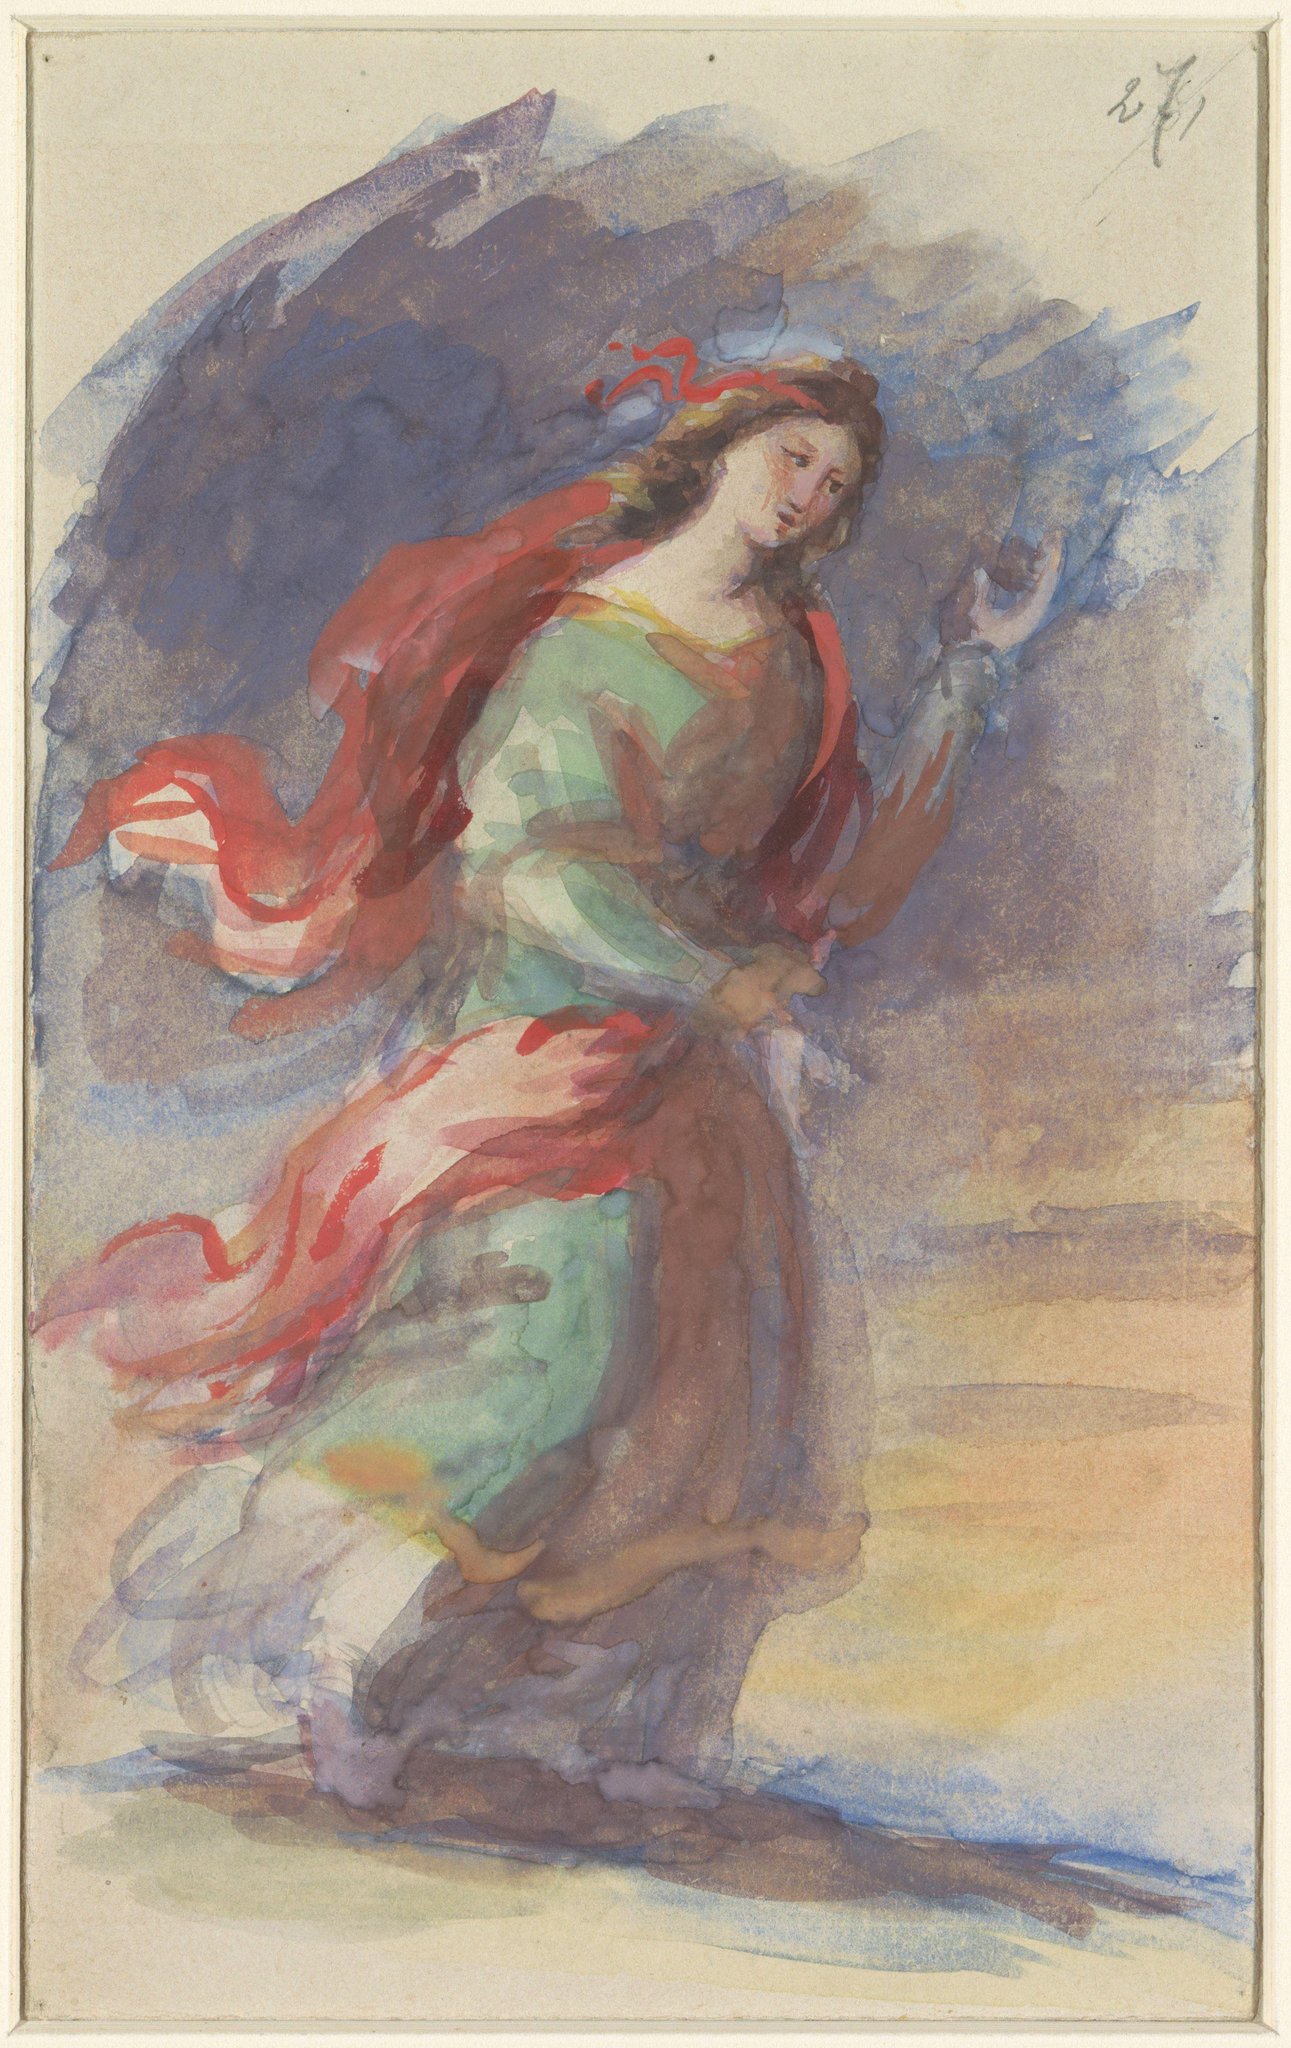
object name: drawing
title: Lopende jonge vrouw, in kleurig, wapperend gewaad, tegen een donkere achtergrond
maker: eduard von heuss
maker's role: draughtsman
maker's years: 1808-1880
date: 1818-1880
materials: paper, watercolor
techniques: brush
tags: standing figure - aa - female human figure